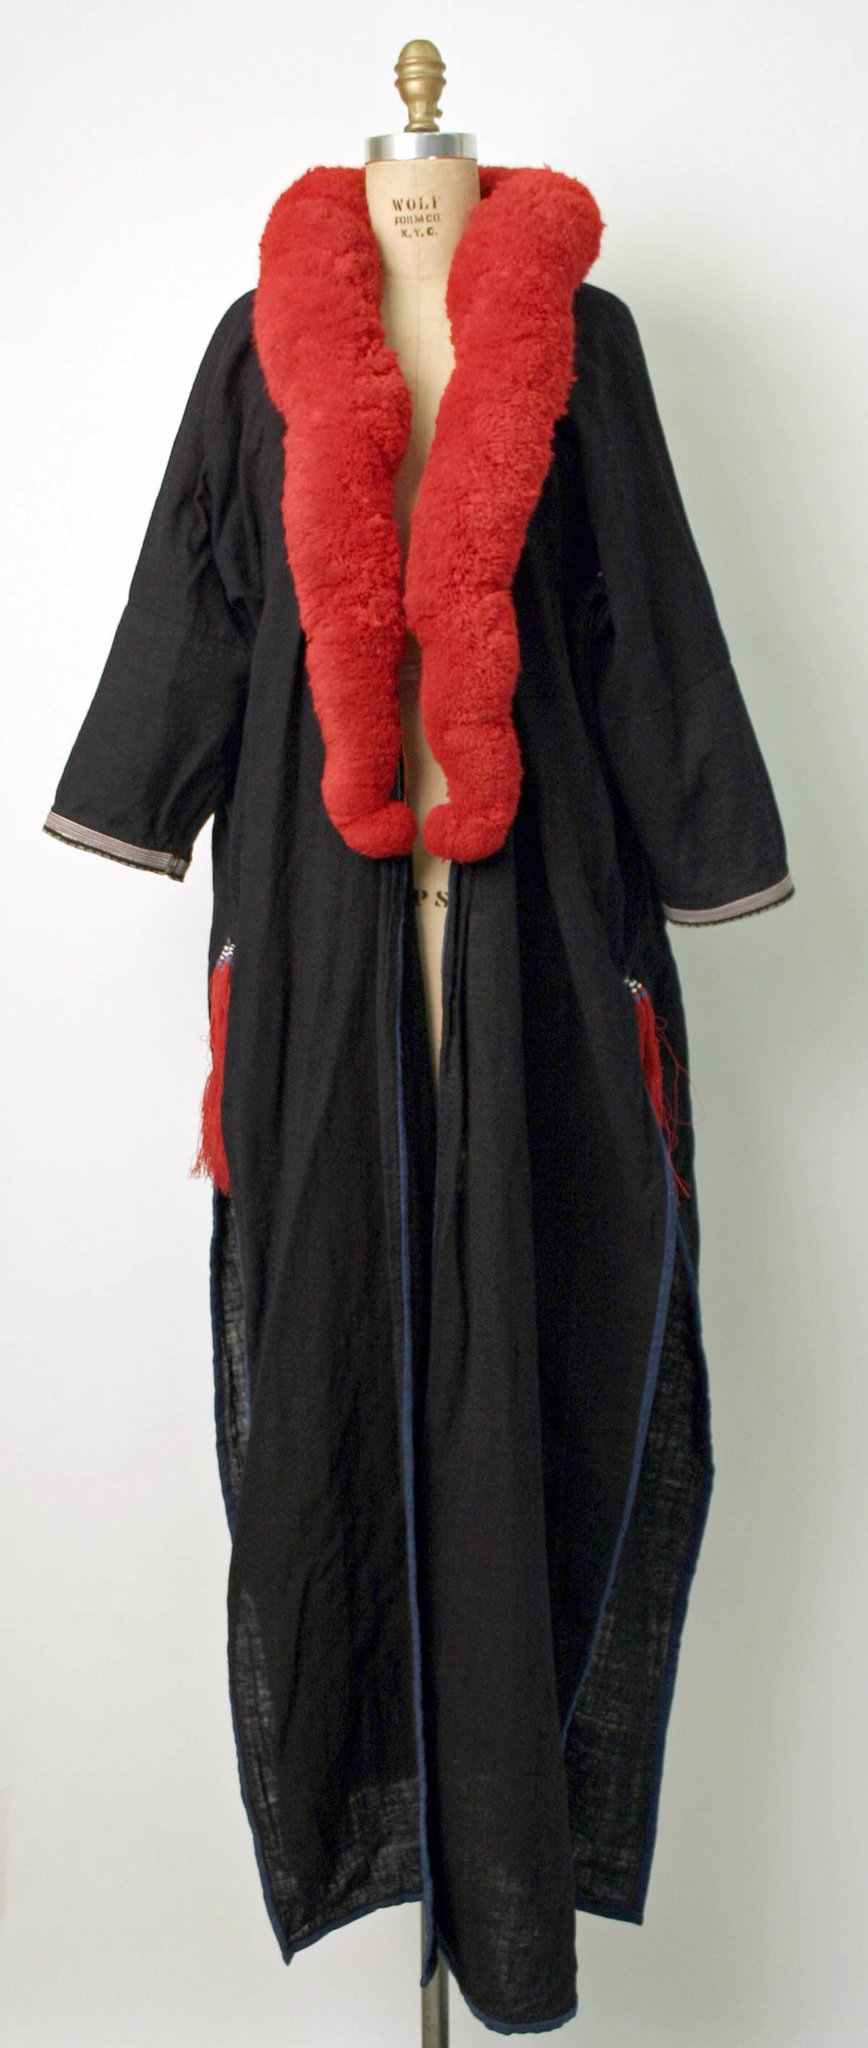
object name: festival costume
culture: thai, lu mien yao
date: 1900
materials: cotton, glass